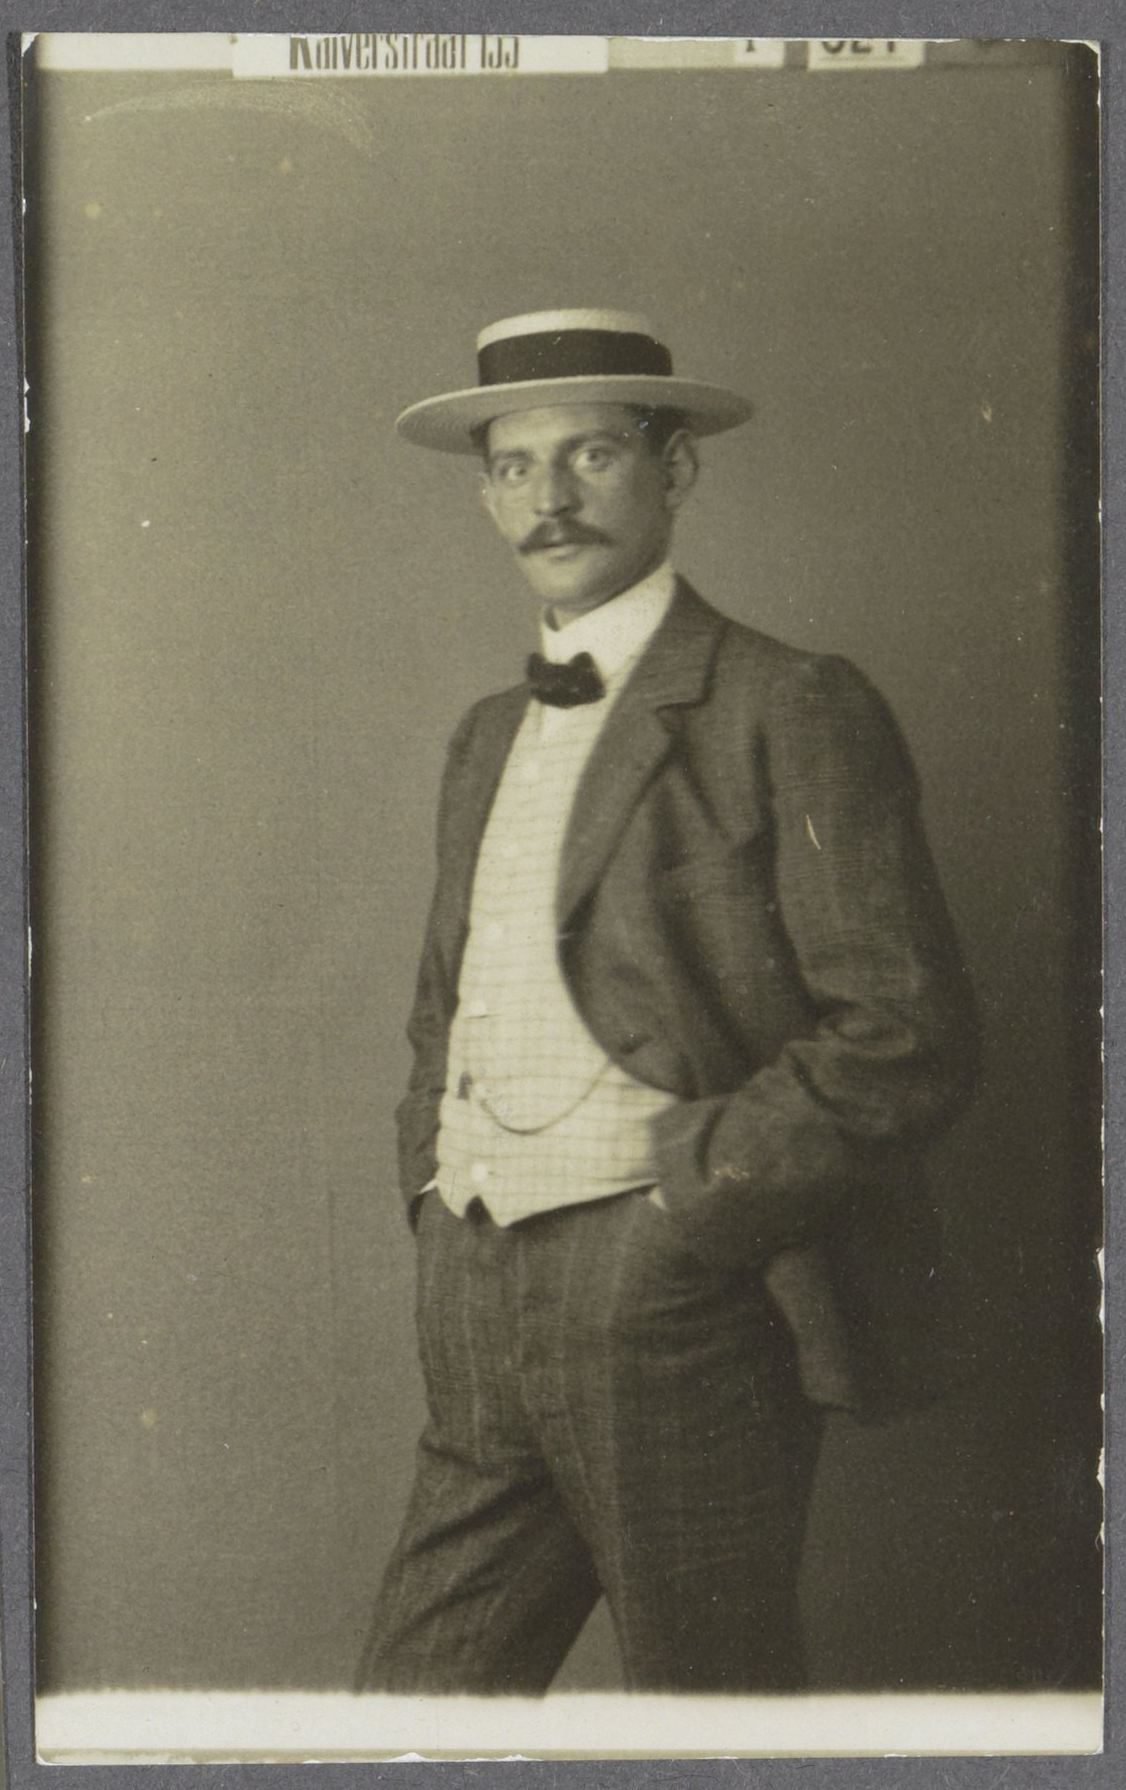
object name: snapshot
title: Portret van een man met een strohoed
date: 1913-1914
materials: paper, cardboard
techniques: gelatin silver print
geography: amsterdam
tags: adult man, historical persons, head-gear: hat, amsterdam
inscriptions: address: ‘Kalverstraat 155’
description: Onderdeel van Fotoalbum met portretten vervaardigd door Nederlandse studio's waaronder automaatfoto's.